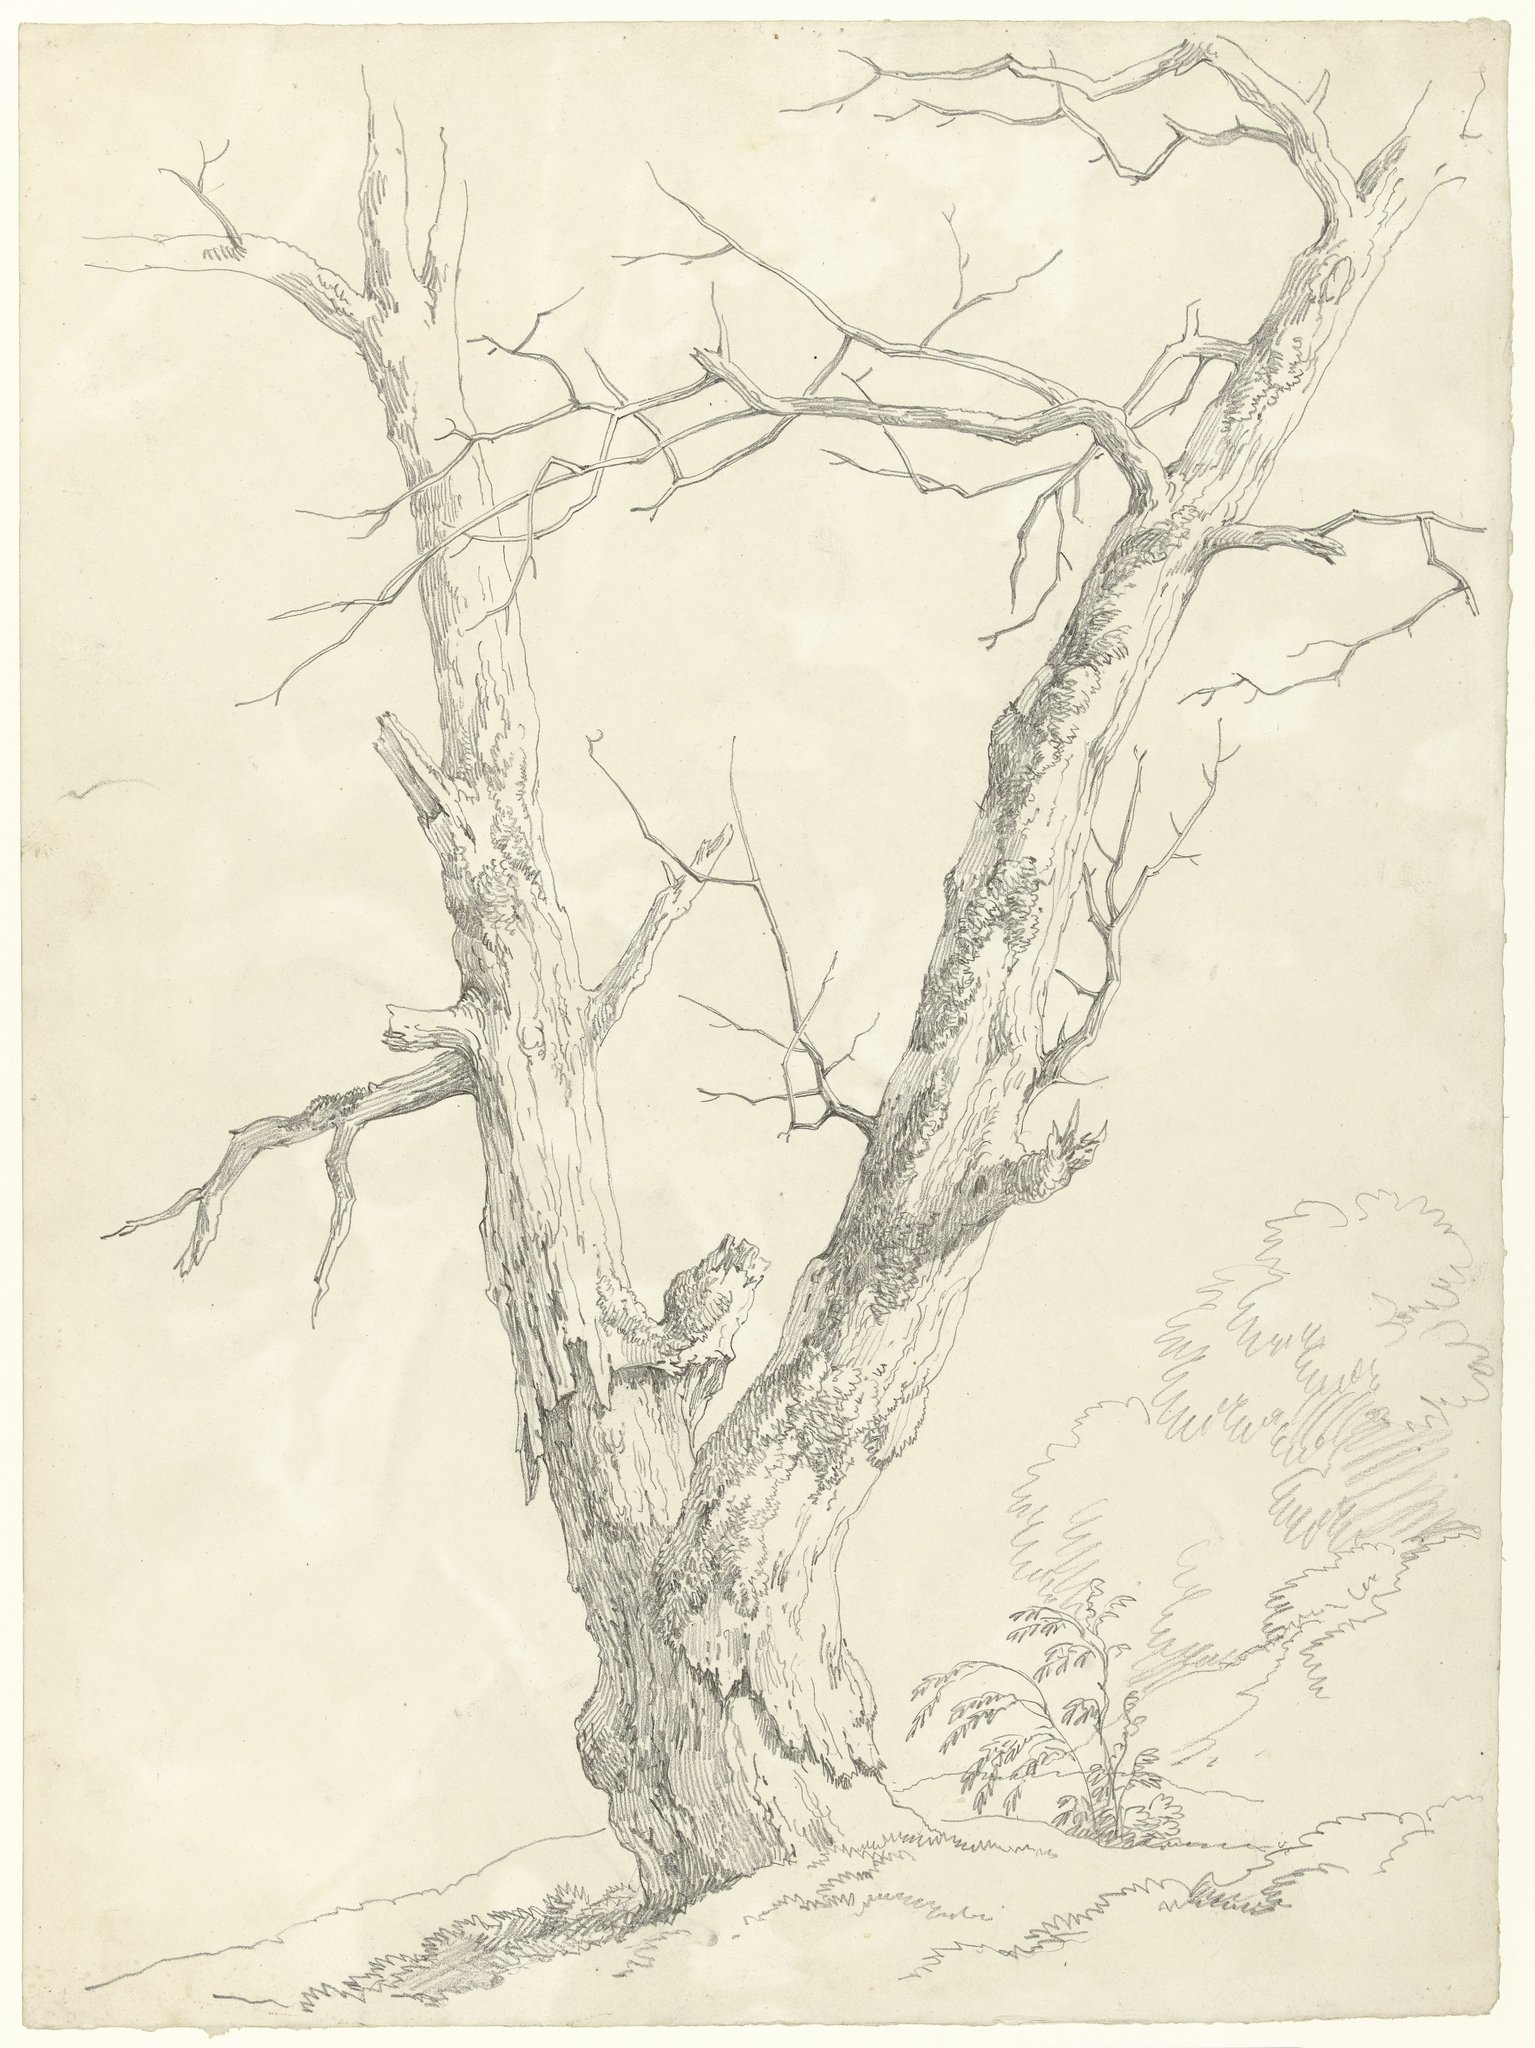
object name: drawing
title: Boom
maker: hendrik voogd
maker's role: draughtsman, painter, print maker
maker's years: 1768-1839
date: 1788-1839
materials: chalk, paper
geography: rome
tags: horse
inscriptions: collector's mark: Lugt 2228, watermark